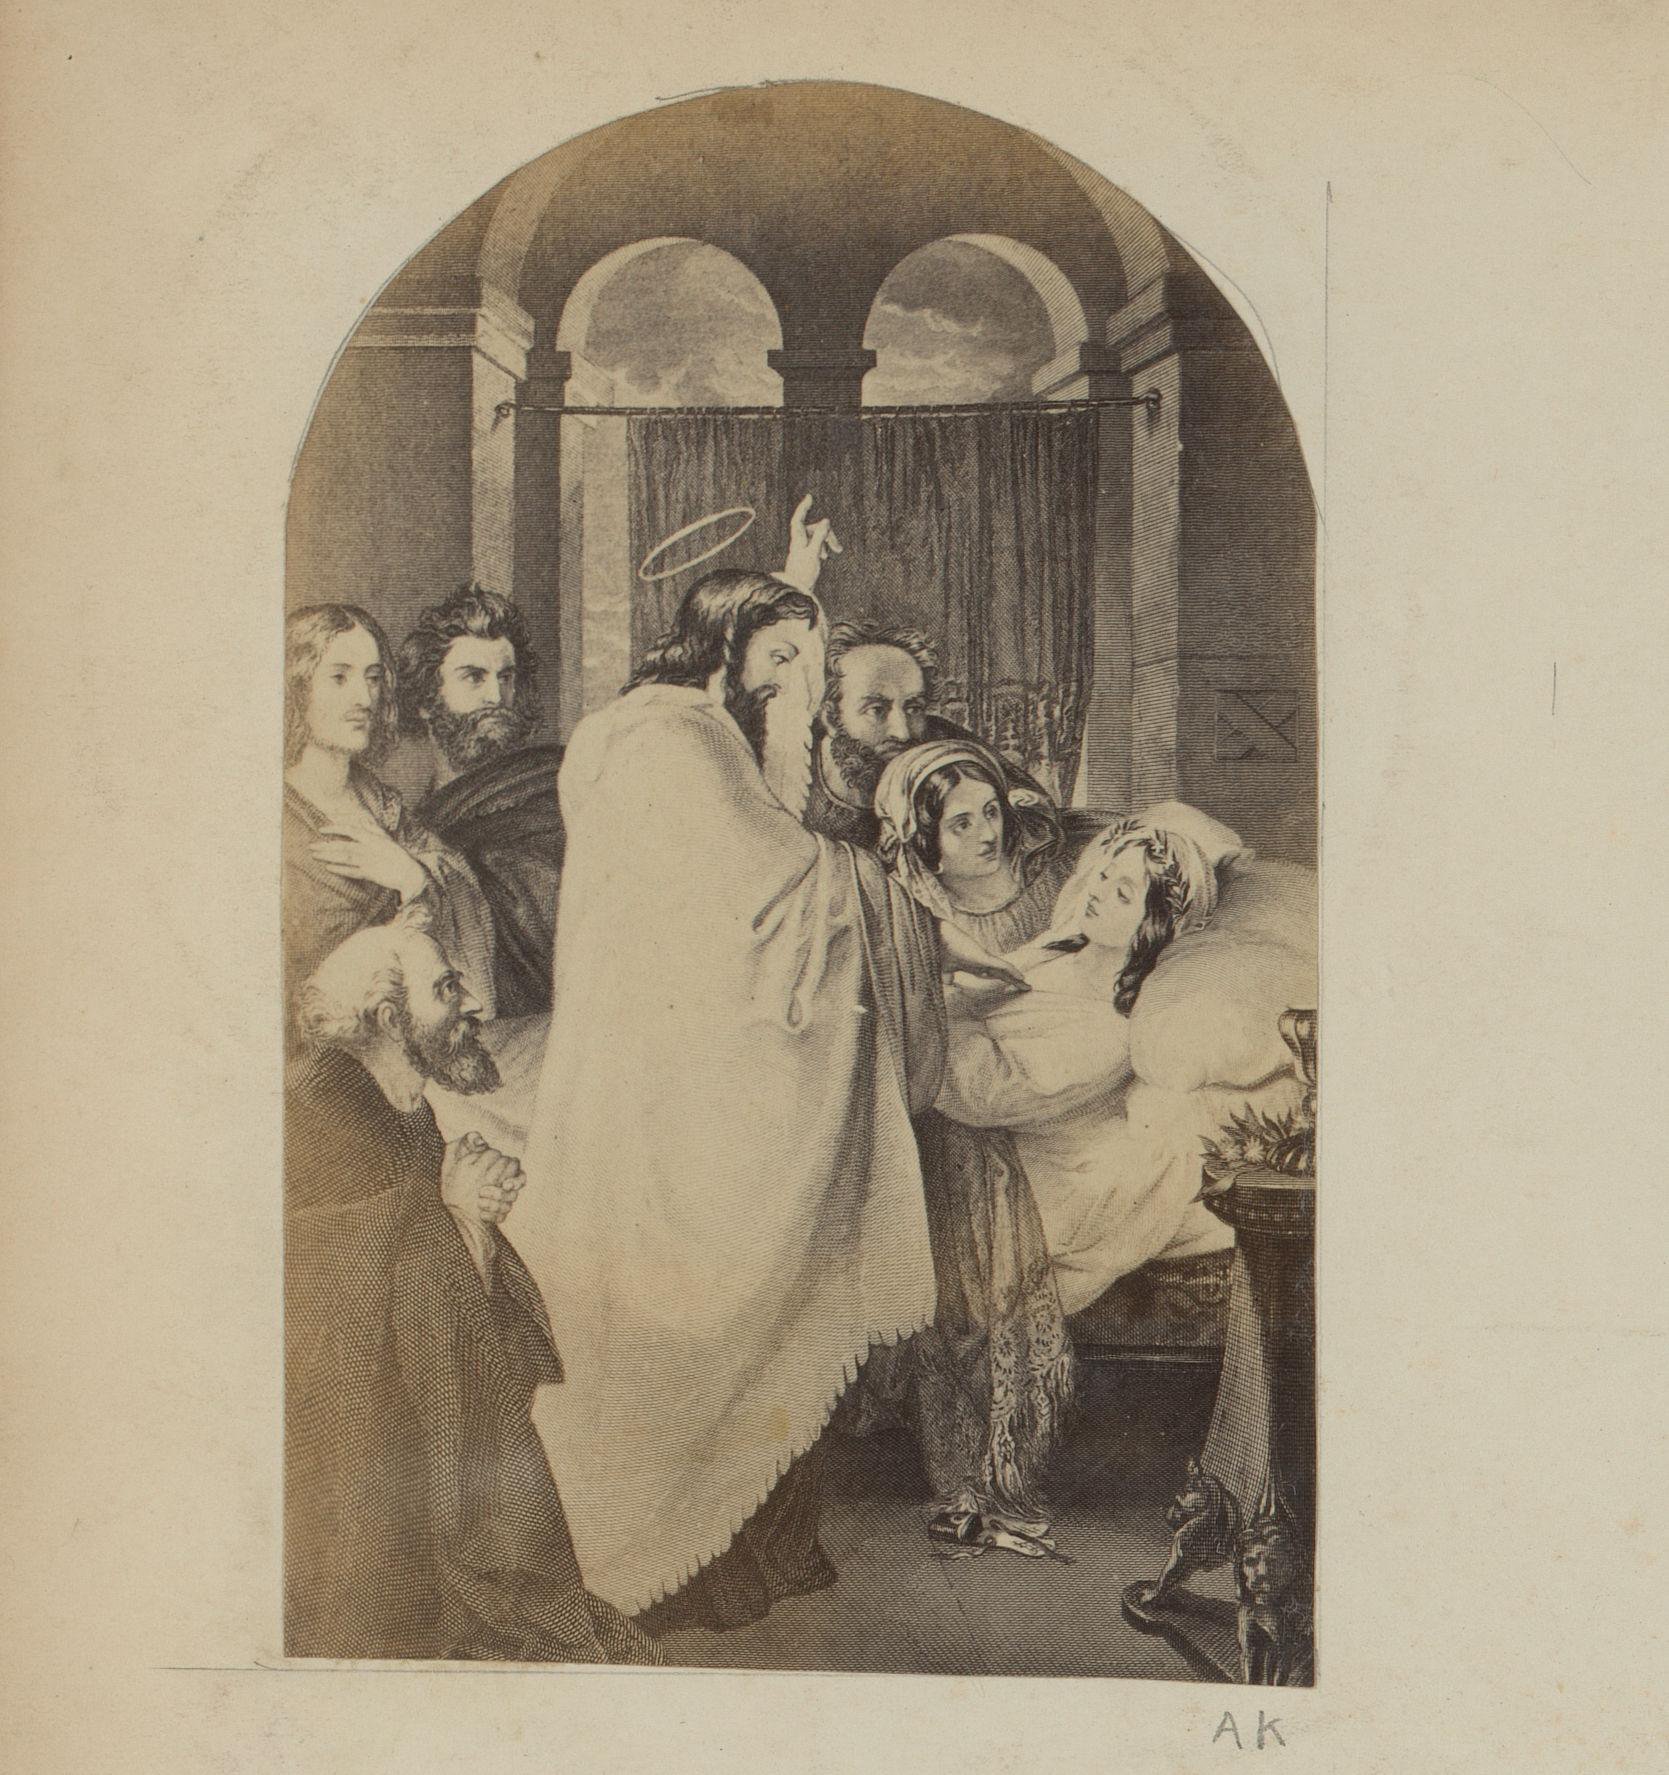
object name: photograph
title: Fotoreproductie van (vermoedelijk) een prent voorstellend Christus aan het ziekbed van een vrouw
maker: Anonymous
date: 1850-1870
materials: paper, photographic support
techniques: albumen print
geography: england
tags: christ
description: Onderdeel van Album met foto's van bezienswaardigheden en landschappen in Engeland en van kunst.